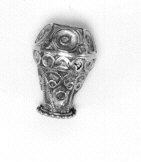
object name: bead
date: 1001-1200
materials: gold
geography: iran